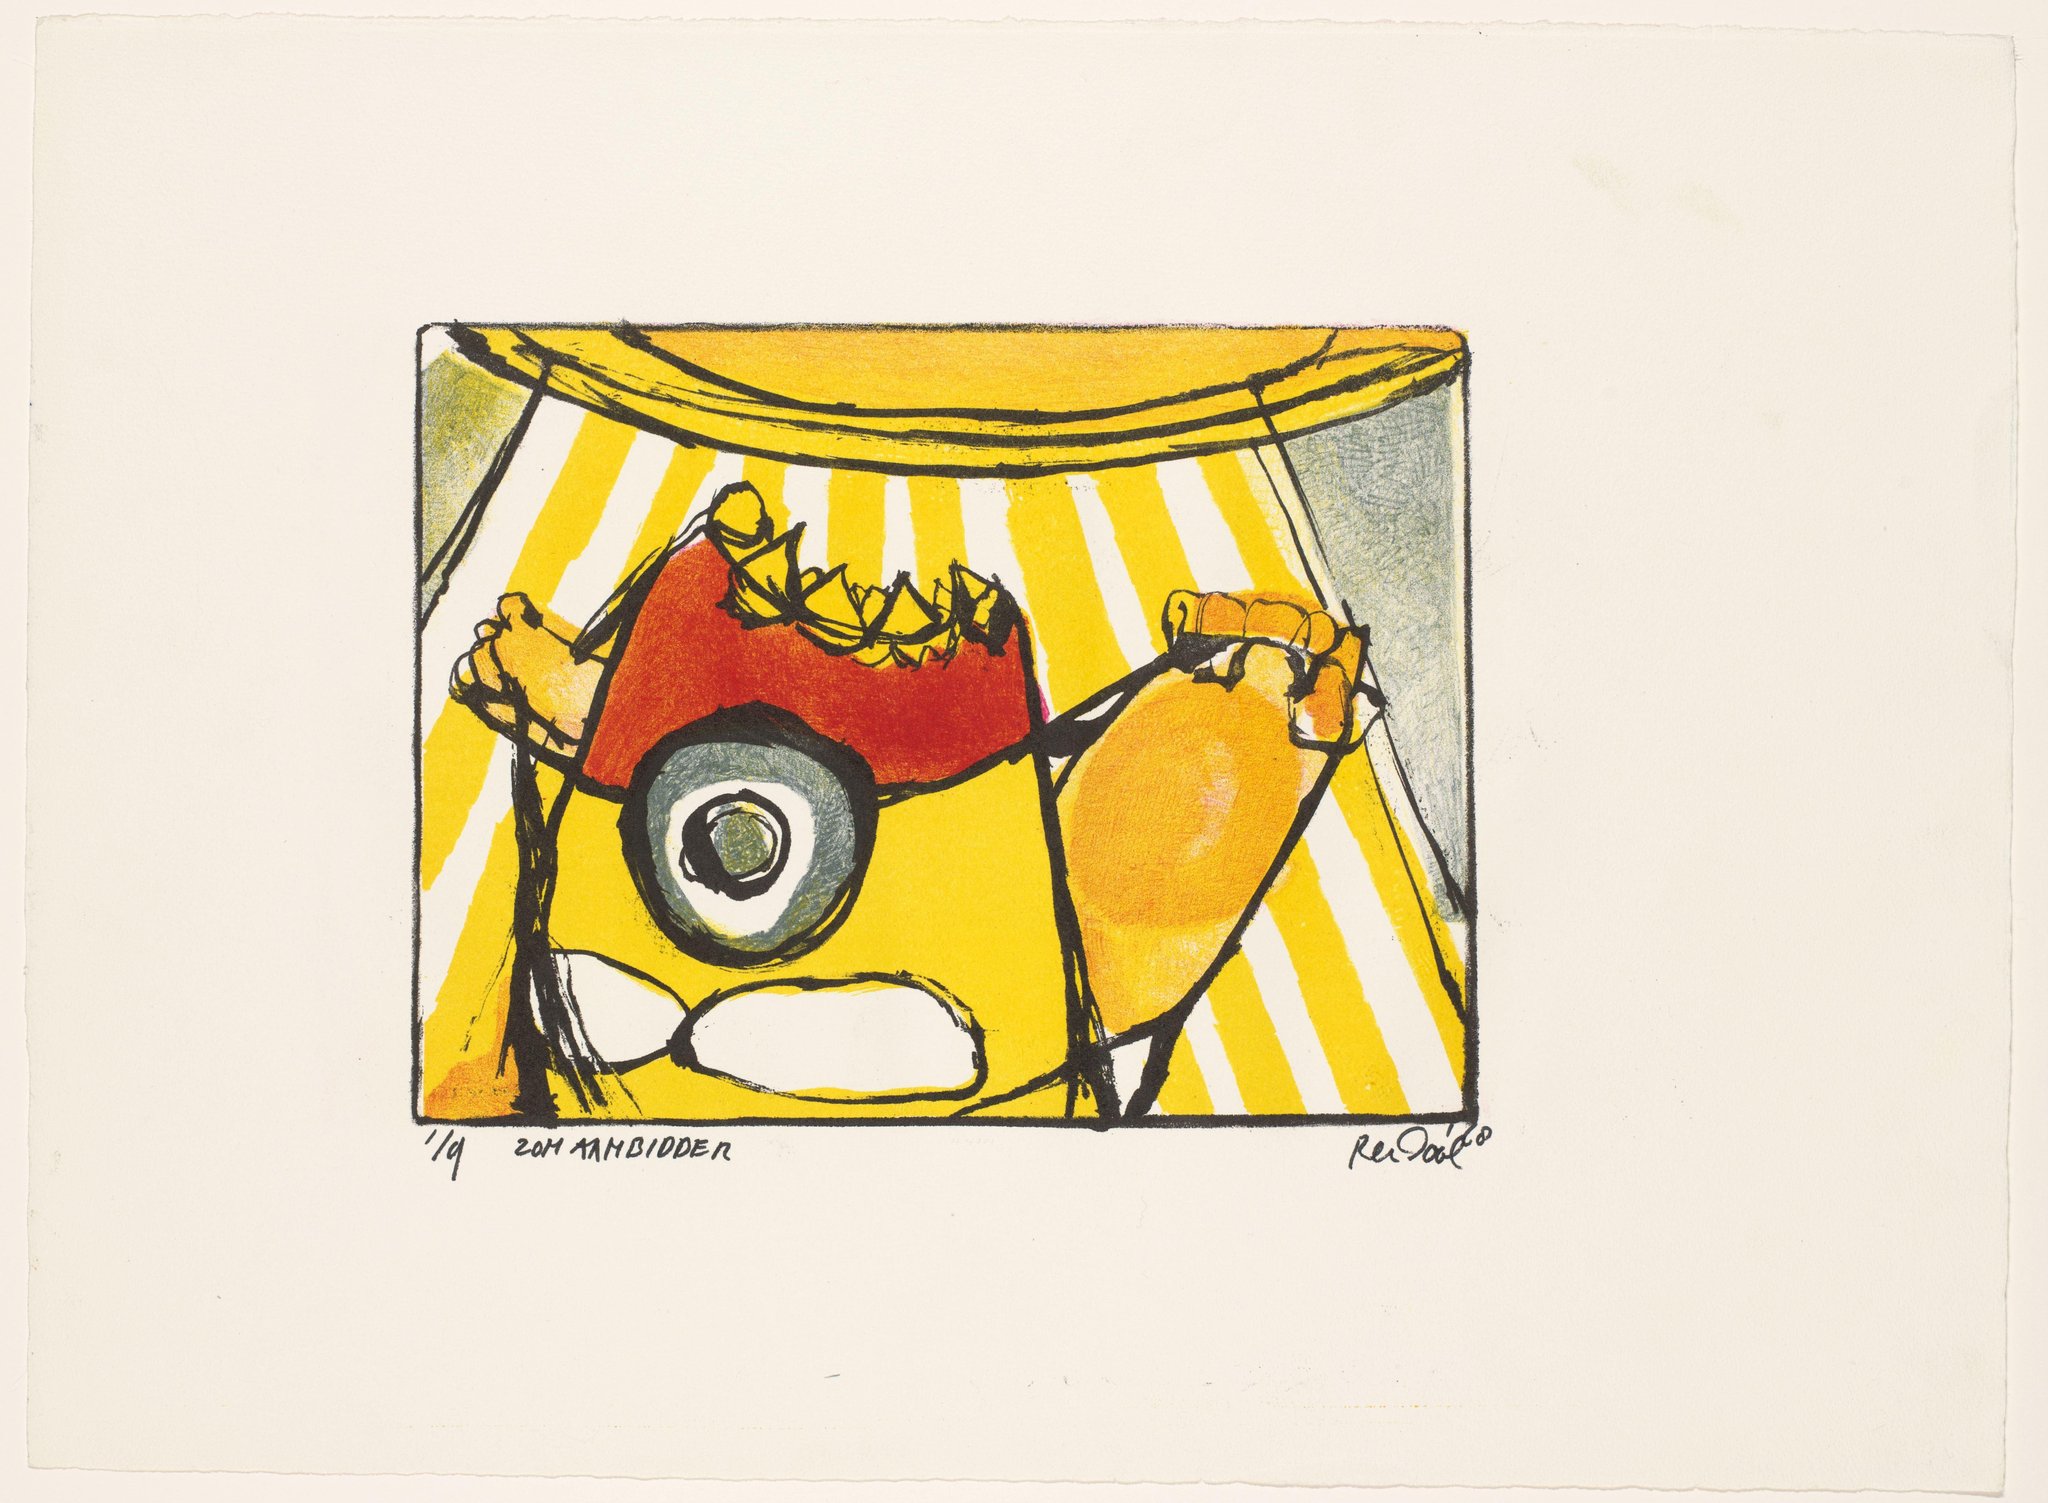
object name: print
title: Zonaanbidder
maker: rein dool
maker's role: draughtsman, painter, print maker, sculptor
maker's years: 1933-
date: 1968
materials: paper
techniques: lithograph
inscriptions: title: ‘ZONAANBIDDER’, signature and date: ‘Rein Dool '68’, edition: ‘1/9’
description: Figuur met opengesperde kaken en opgeheven armen onder stralende zon.